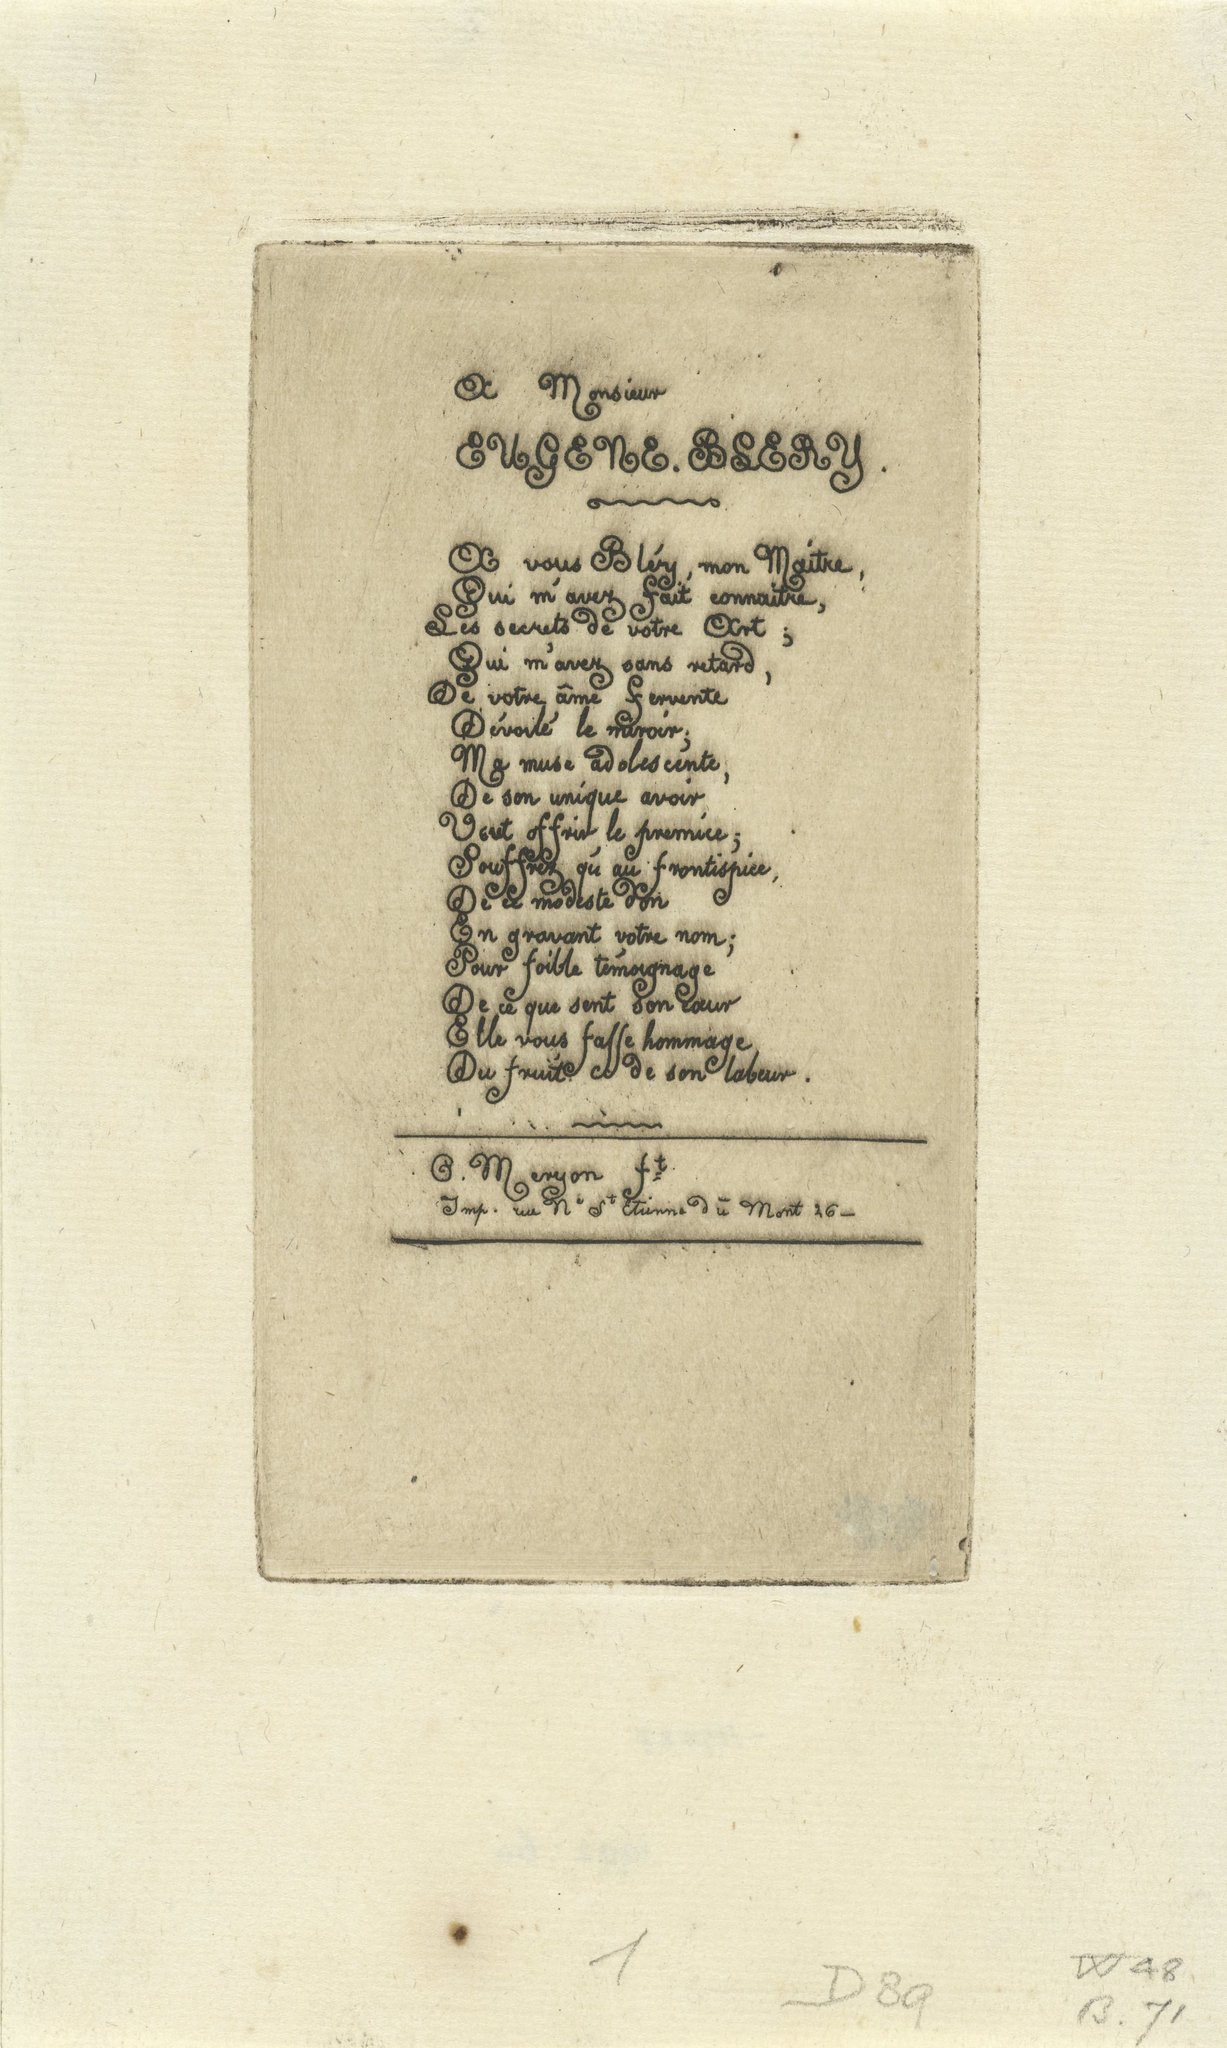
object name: print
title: Vers a Eugène Bléry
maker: charles meryon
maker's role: print maker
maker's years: 1821-1868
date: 1854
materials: paper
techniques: etching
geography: france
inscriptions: collector's mark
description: Gedicht opgedragen aan Eugène Bléry zoals blijkt uit de aanhef boven het vers: A Monsieur Eugène Bléry. Daaronder staat het gedicht van zestien regels.